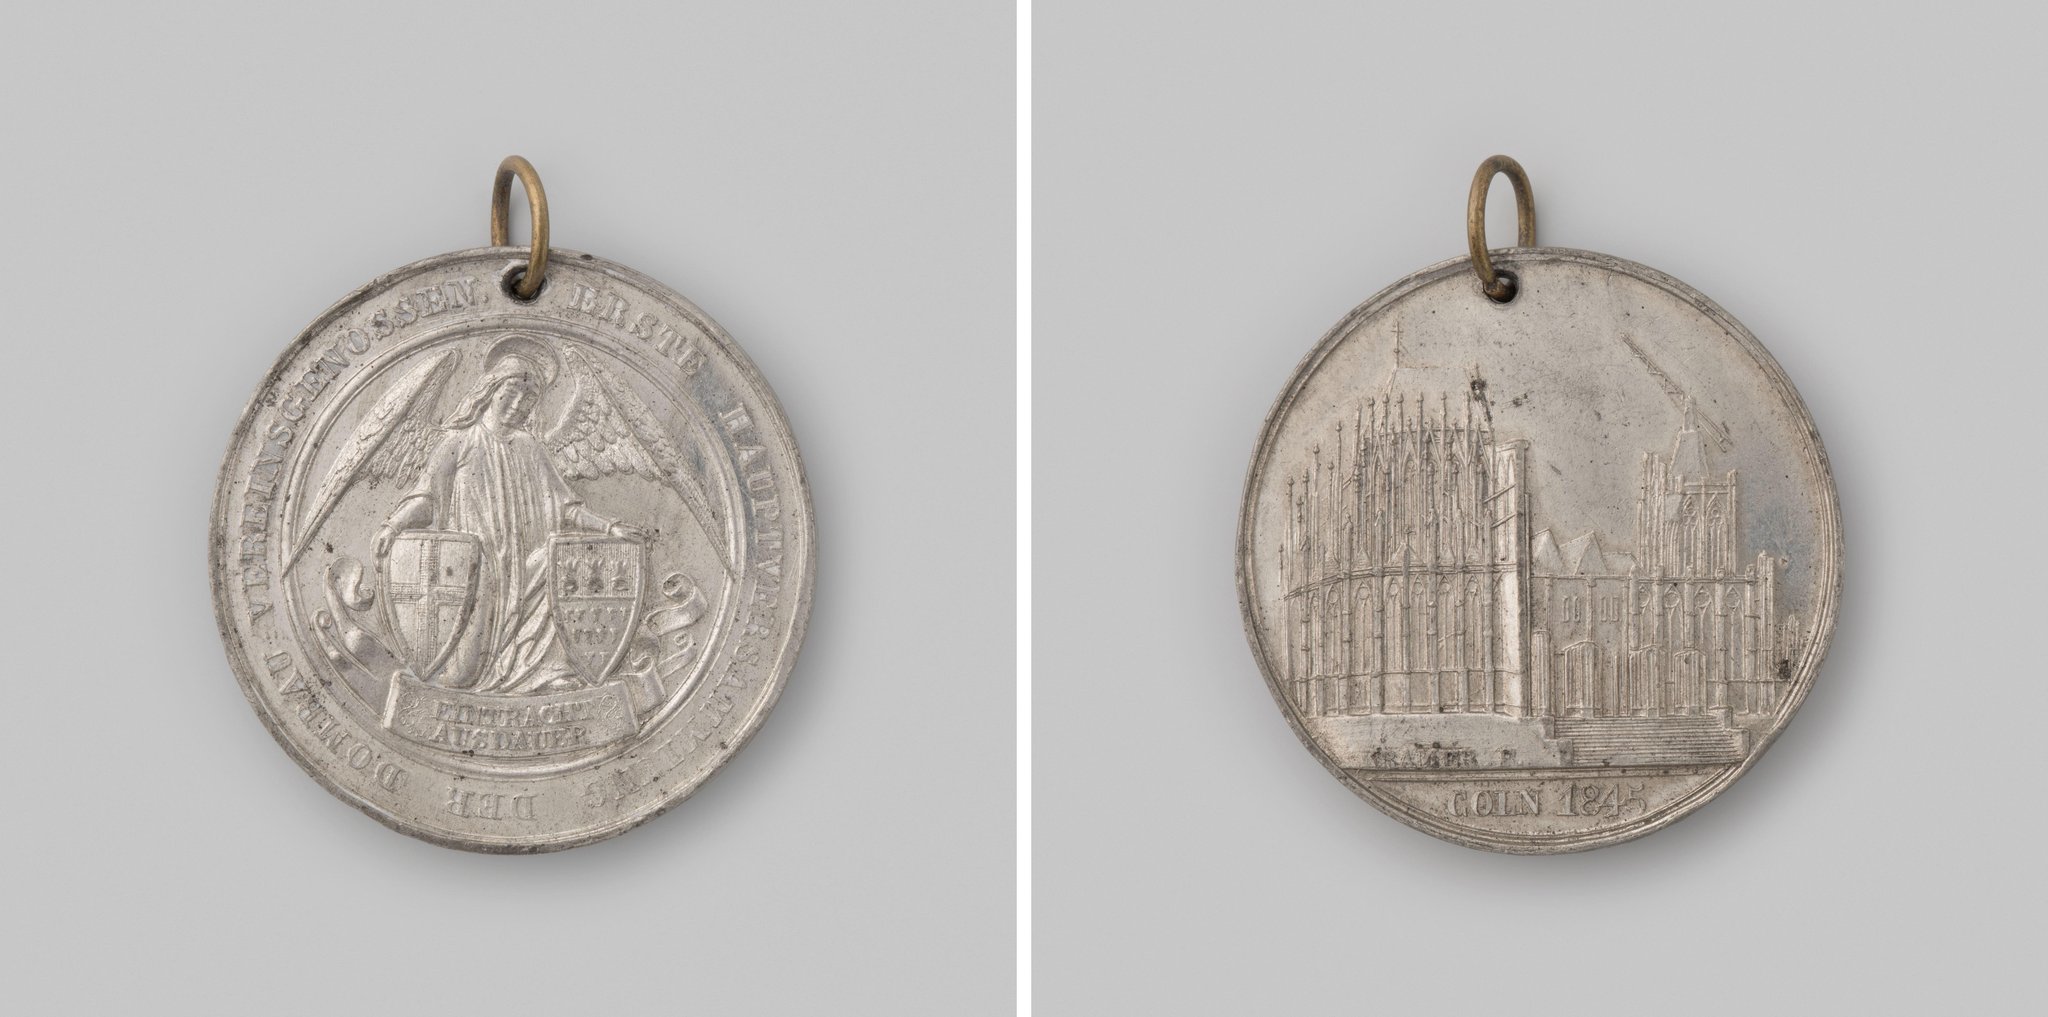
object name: history medal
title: Eerste bijeenkomst van de Dombouw-vereniging te Keulen 1845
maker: kramer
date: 1845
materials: tin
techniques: striking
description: Tinnen penning met gat en draagring, op de voorzijde de Dom van Keulen in aanbouw, met afsnedetekst, op de keerzijde een engel met twee wapenschilden en banderol, met omschrift.